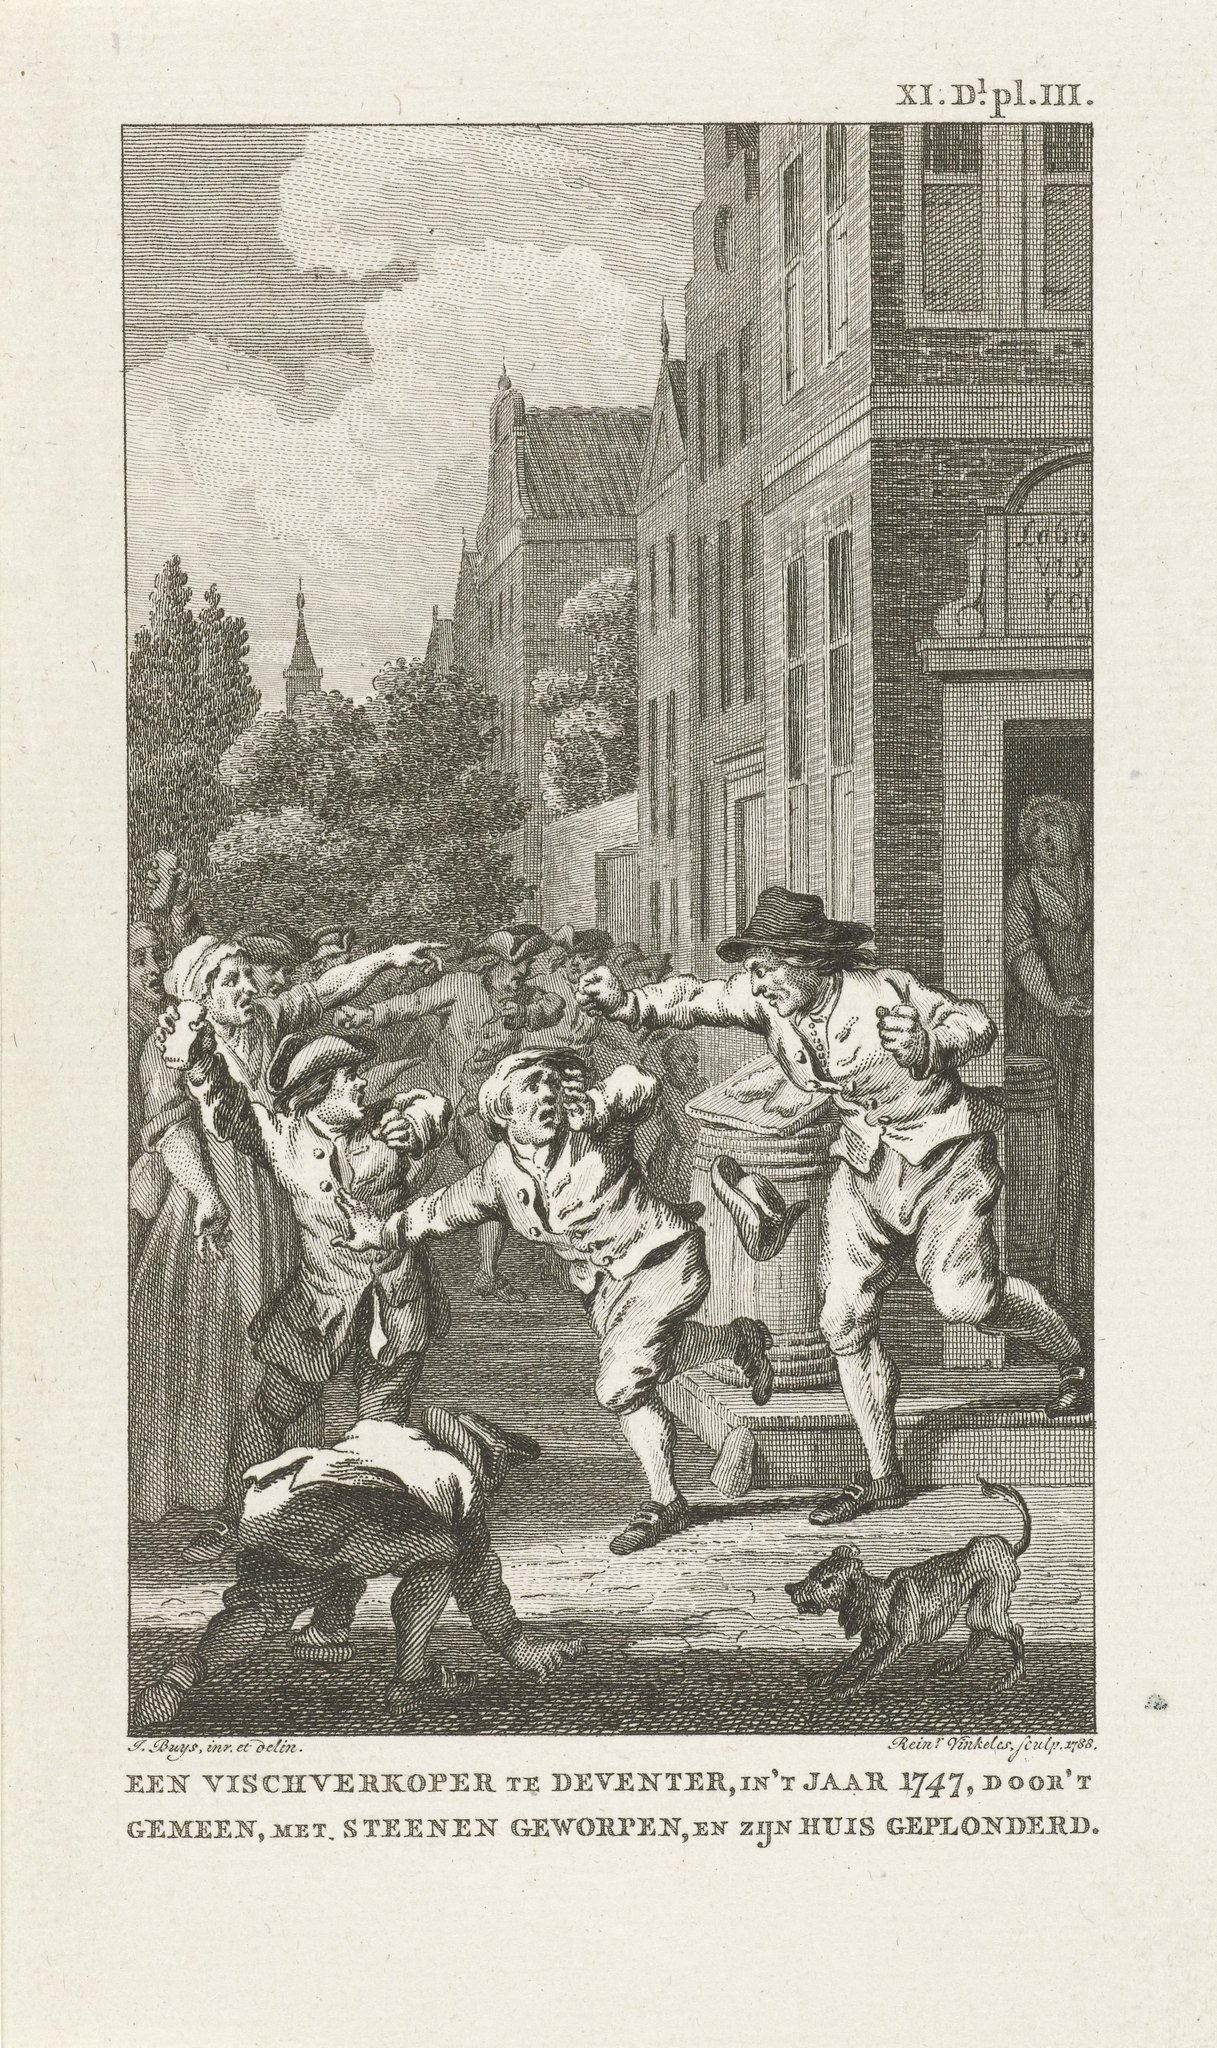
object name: history print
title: Plundering van het huis van een Fransgezinde visverkoper te Deventer, 1747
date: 1788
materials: paper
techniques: etching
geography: northern netherlands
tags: plundering ~ riot, deventer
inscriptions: collector's mark: Lugt 2228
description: Een Fransgezinde visverkoper te Deventer mishandeld en zijn huis geplunderd door oproerkraaiers, 20 september 1747. Gemerkt rechtsboven: XI. Dl. pl. III.